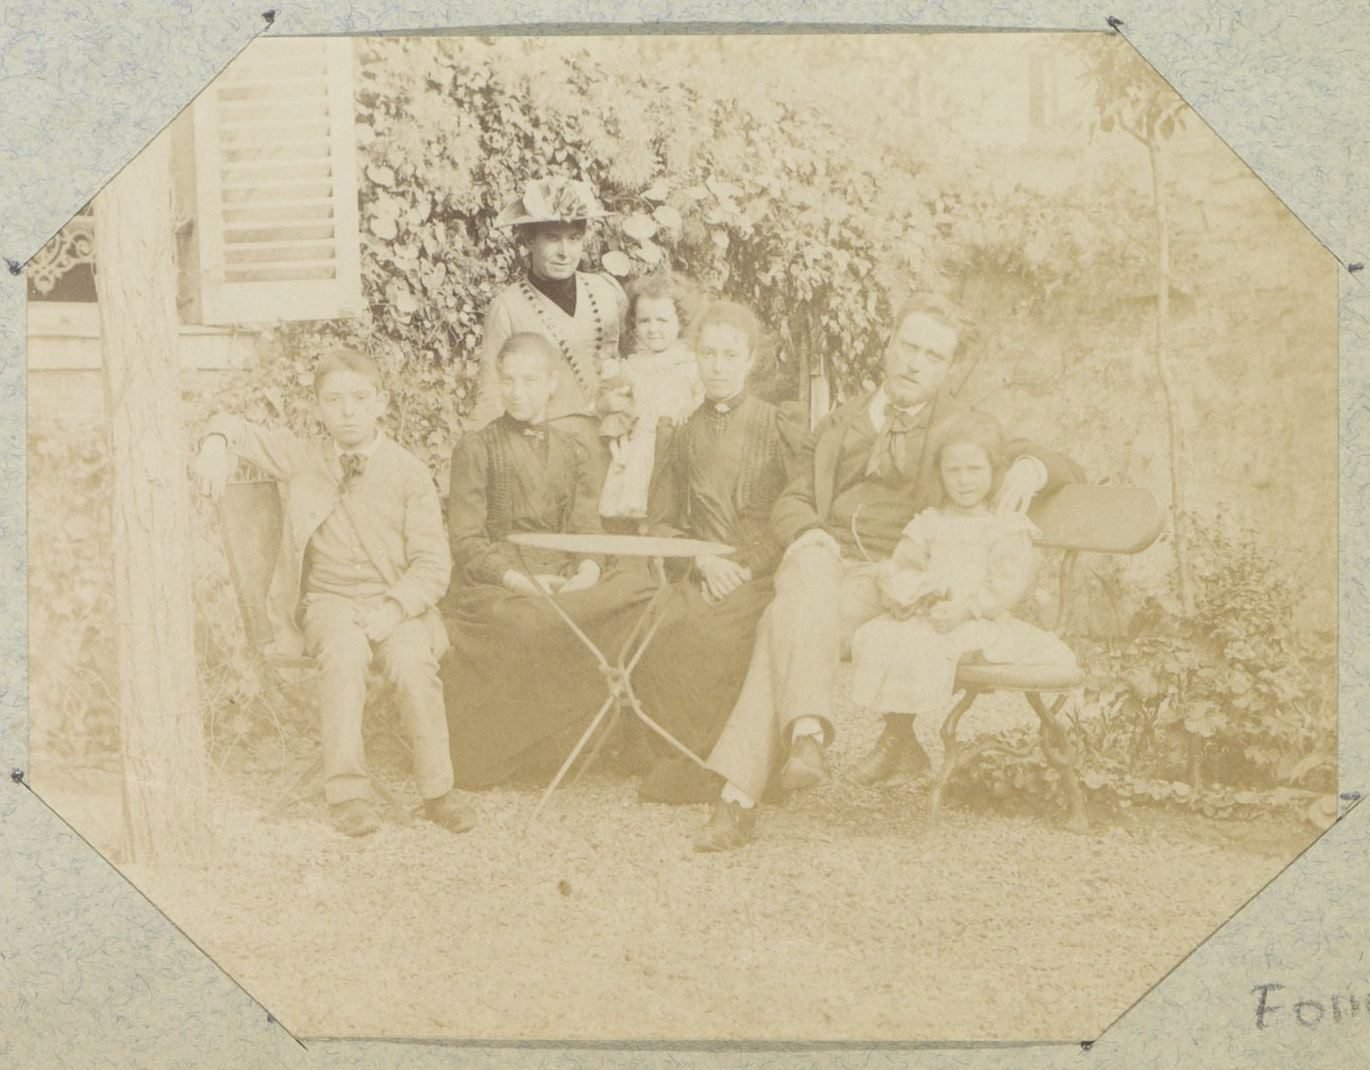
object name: photograph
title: Groepsportret van een (vermoedelijk) Franse familie in een tuin bij een huis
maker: Anonymous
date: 1880-1900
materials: paper, photographic support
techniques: albumen print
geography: france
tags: family group, especially parents with their child(ren), france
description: Onderdeel van Album van een Franse amateur met foto's van Frankrijk, Algerije, Palmyra, de Wereldtentoonstelling van 1900 en van bekende Fransen.